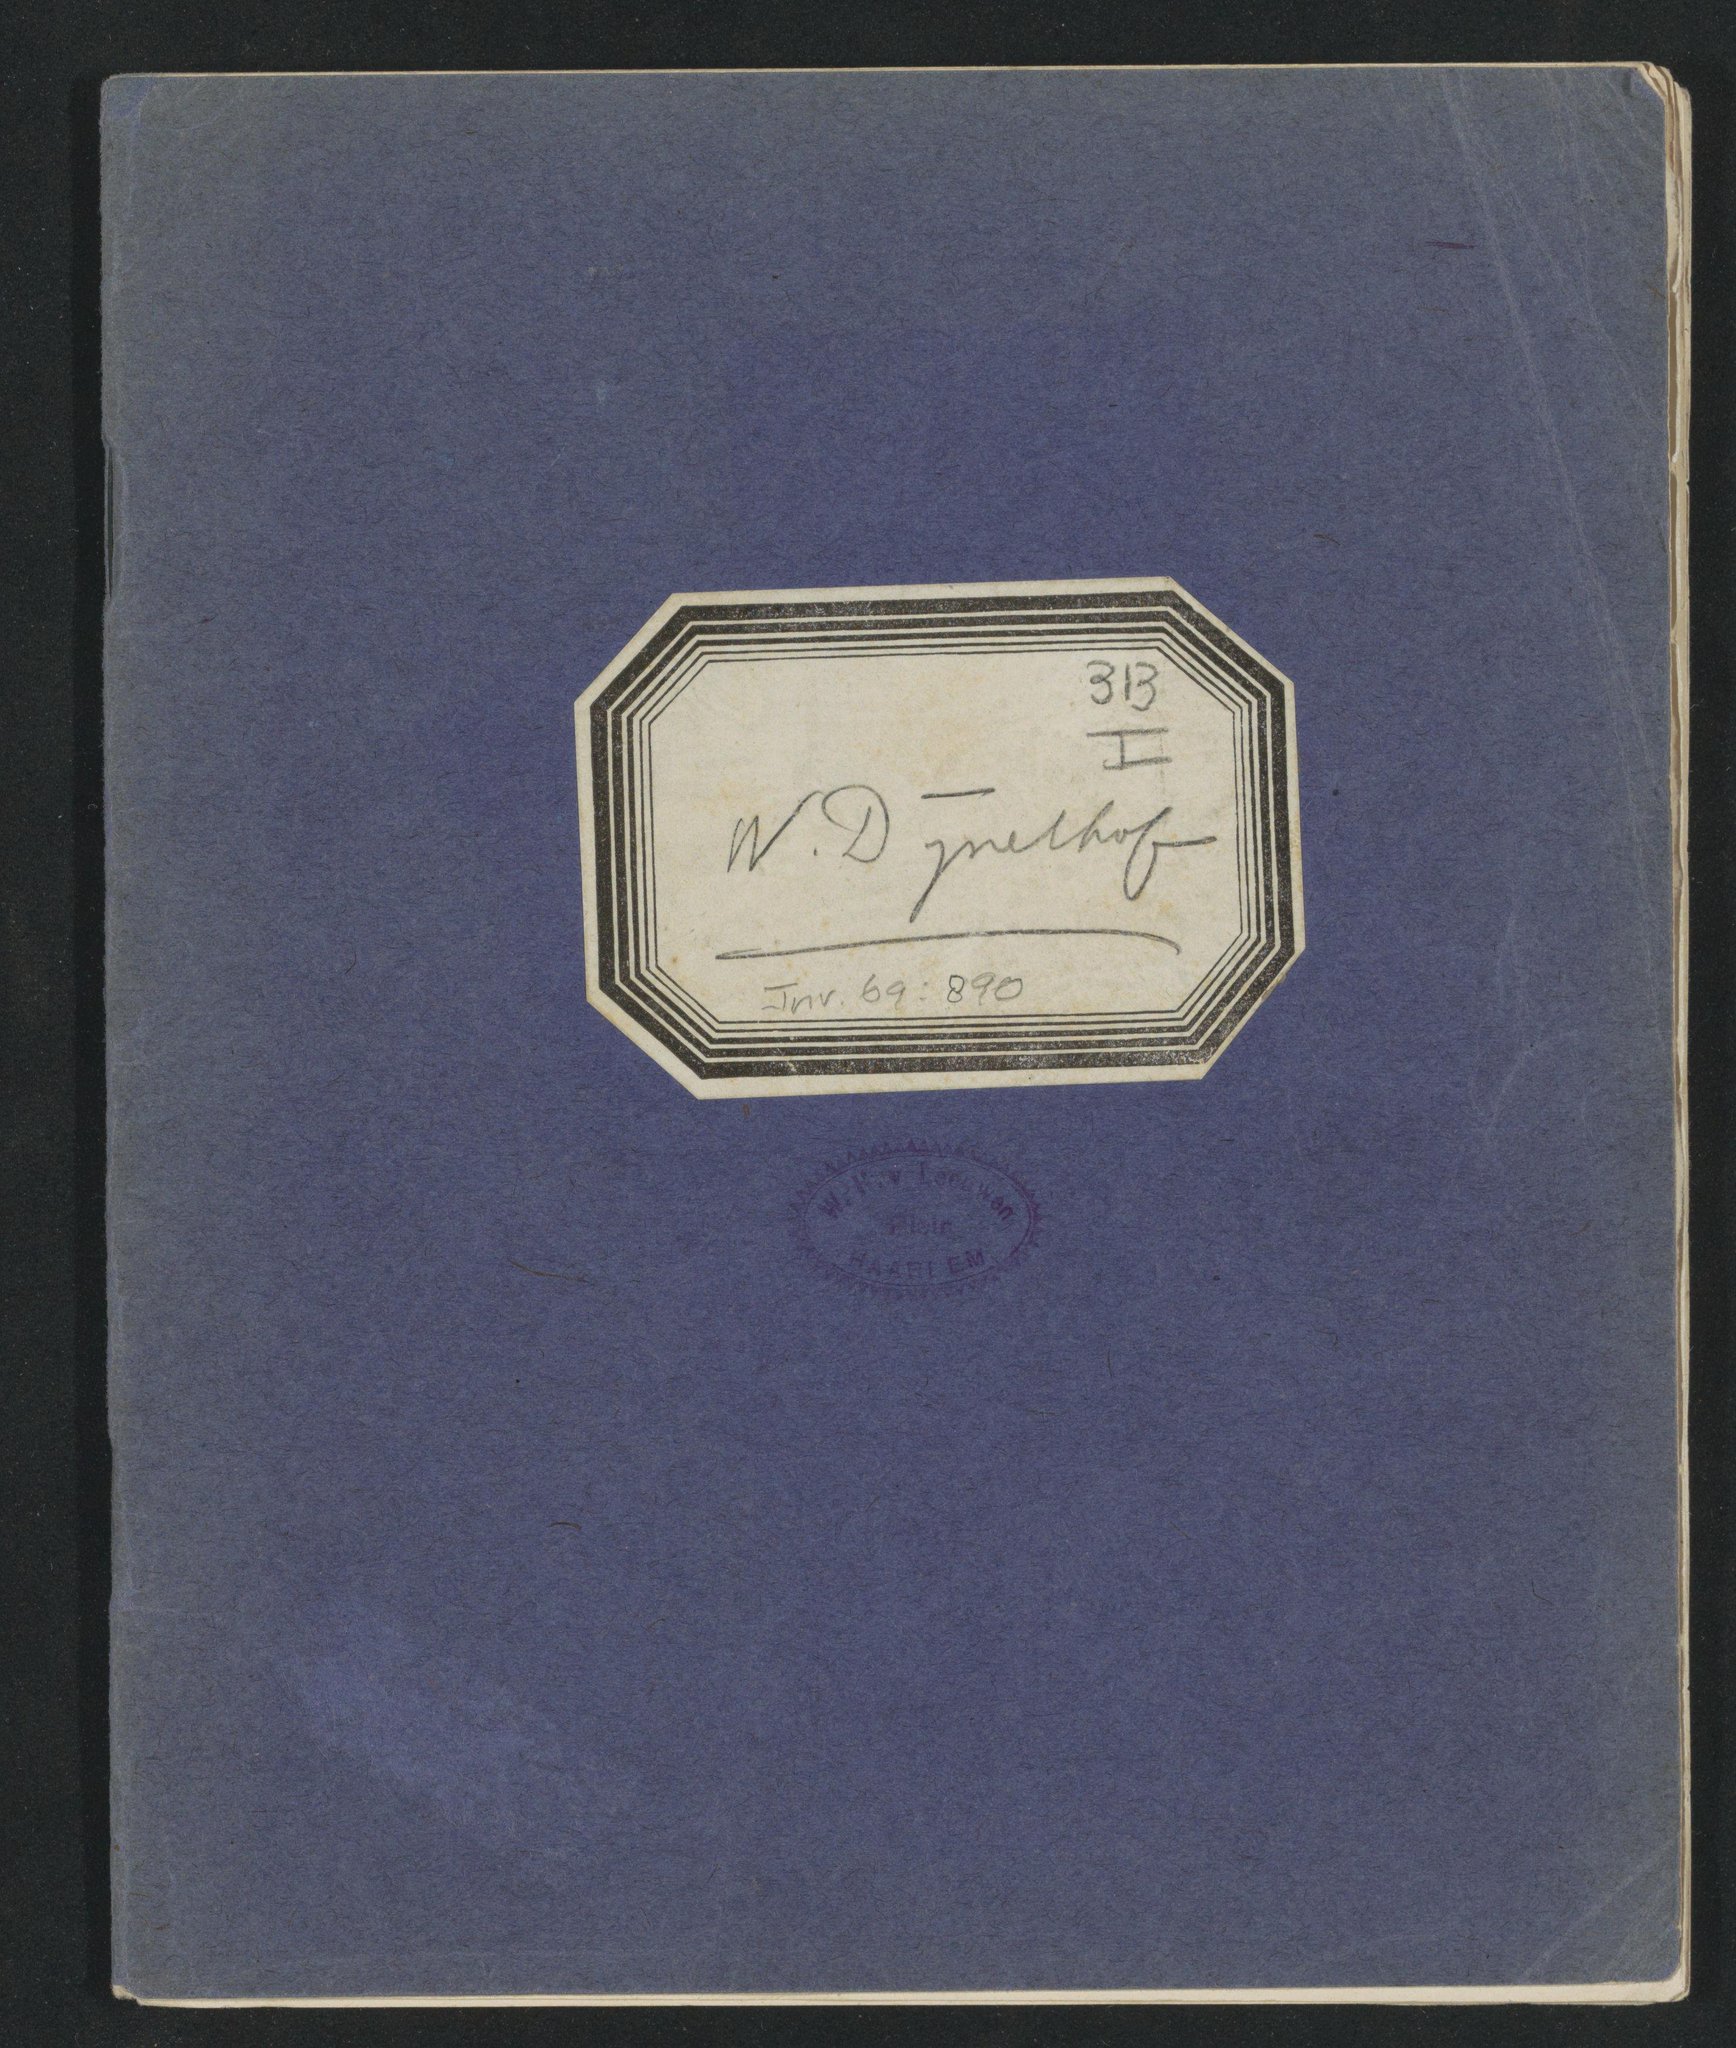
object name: album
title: Album met 17 bladen met ingeplakte tekeningen en prenten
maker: gerrit willem dijsselhof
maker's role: designer, draughtsman, print maker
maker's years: 1866-1924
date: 1876-1924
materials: cardboard, chalk, paint, ink, paper, pencil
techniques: etching, pen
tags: decoration of printed matter, ex-libris, foliage, tendrils, branches ~ ornament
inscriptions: collector's mark: Lugt 2228a, label: ‘W.D. Dijsselhof’, label: ‘S/ SK/1900/ Ja[...]/ Dijsselhof/ Deventer/ Schrift met/ ex-libris &/ schetsen’, retailer's mark: ‘W.H. v Leeuwen/ [...[in/ HAARLEM’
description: Album bestaande uit 17 bladen met ingeplakte tekeningen en prenten, waaronder ex-libris, monogrammen, een kalenderblad, boekversieringen en ornamenten.